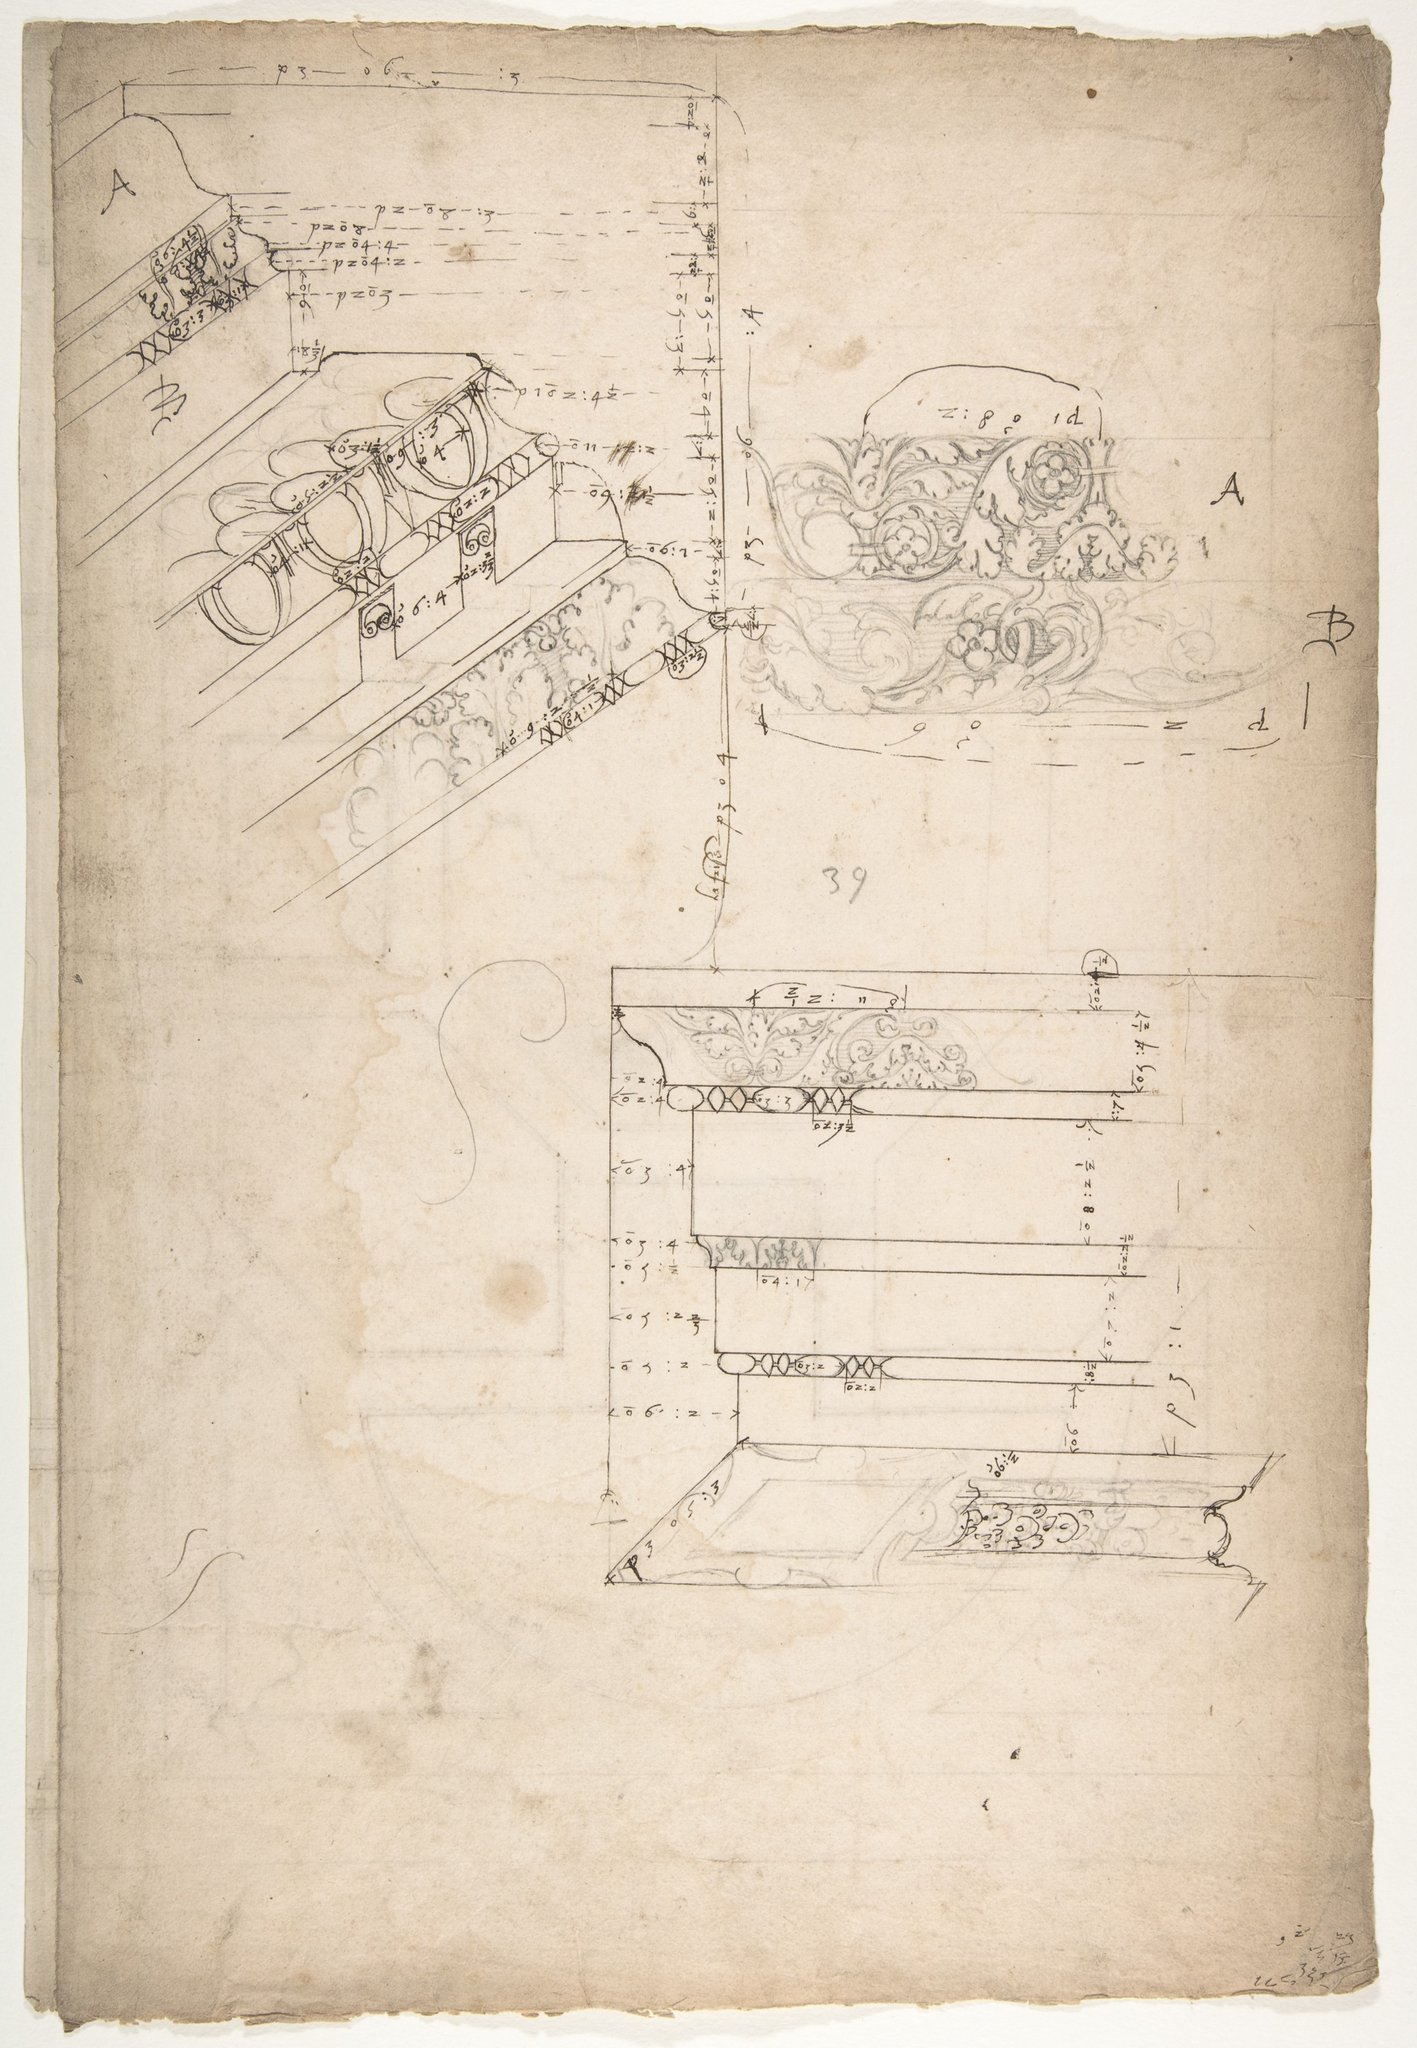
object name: collection ornament architecture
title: Unidentified, cornice, projection; architrave, projection (recto) Unidentified, ceiling, plan (verso)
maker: anonymous, french, 16th century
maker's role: draftsman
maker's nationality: french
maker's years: 1500-1600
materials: chalk, ink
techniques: incising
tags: architecture